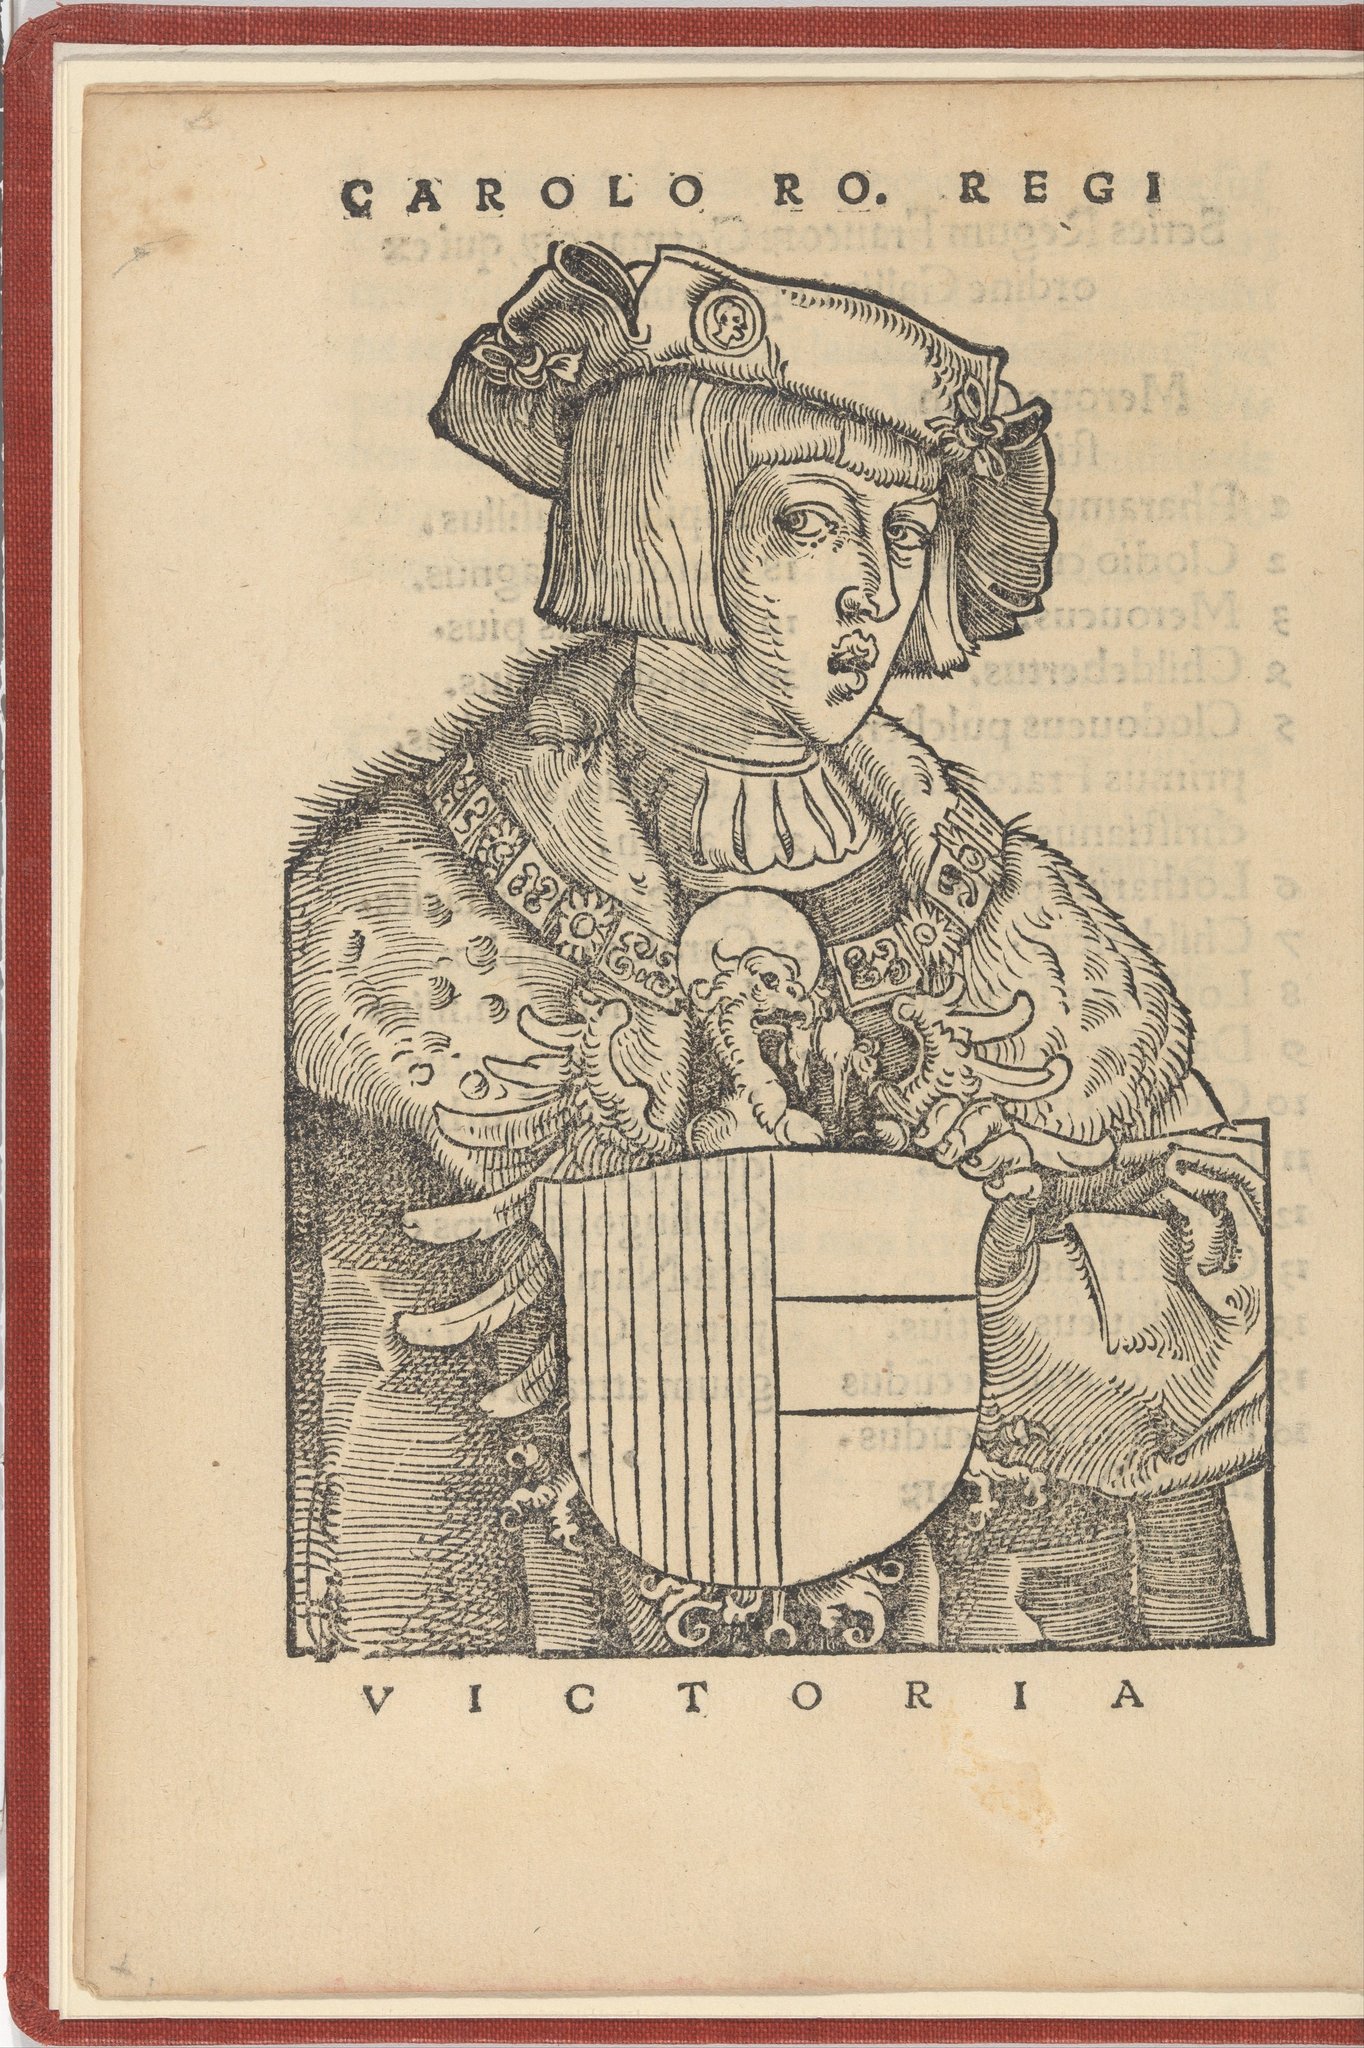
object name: book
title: Libertas Germaniae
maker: hieronymus gebweiler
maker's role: author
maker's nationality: german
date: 1519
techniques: woodcut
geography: france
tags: women,coat of arms